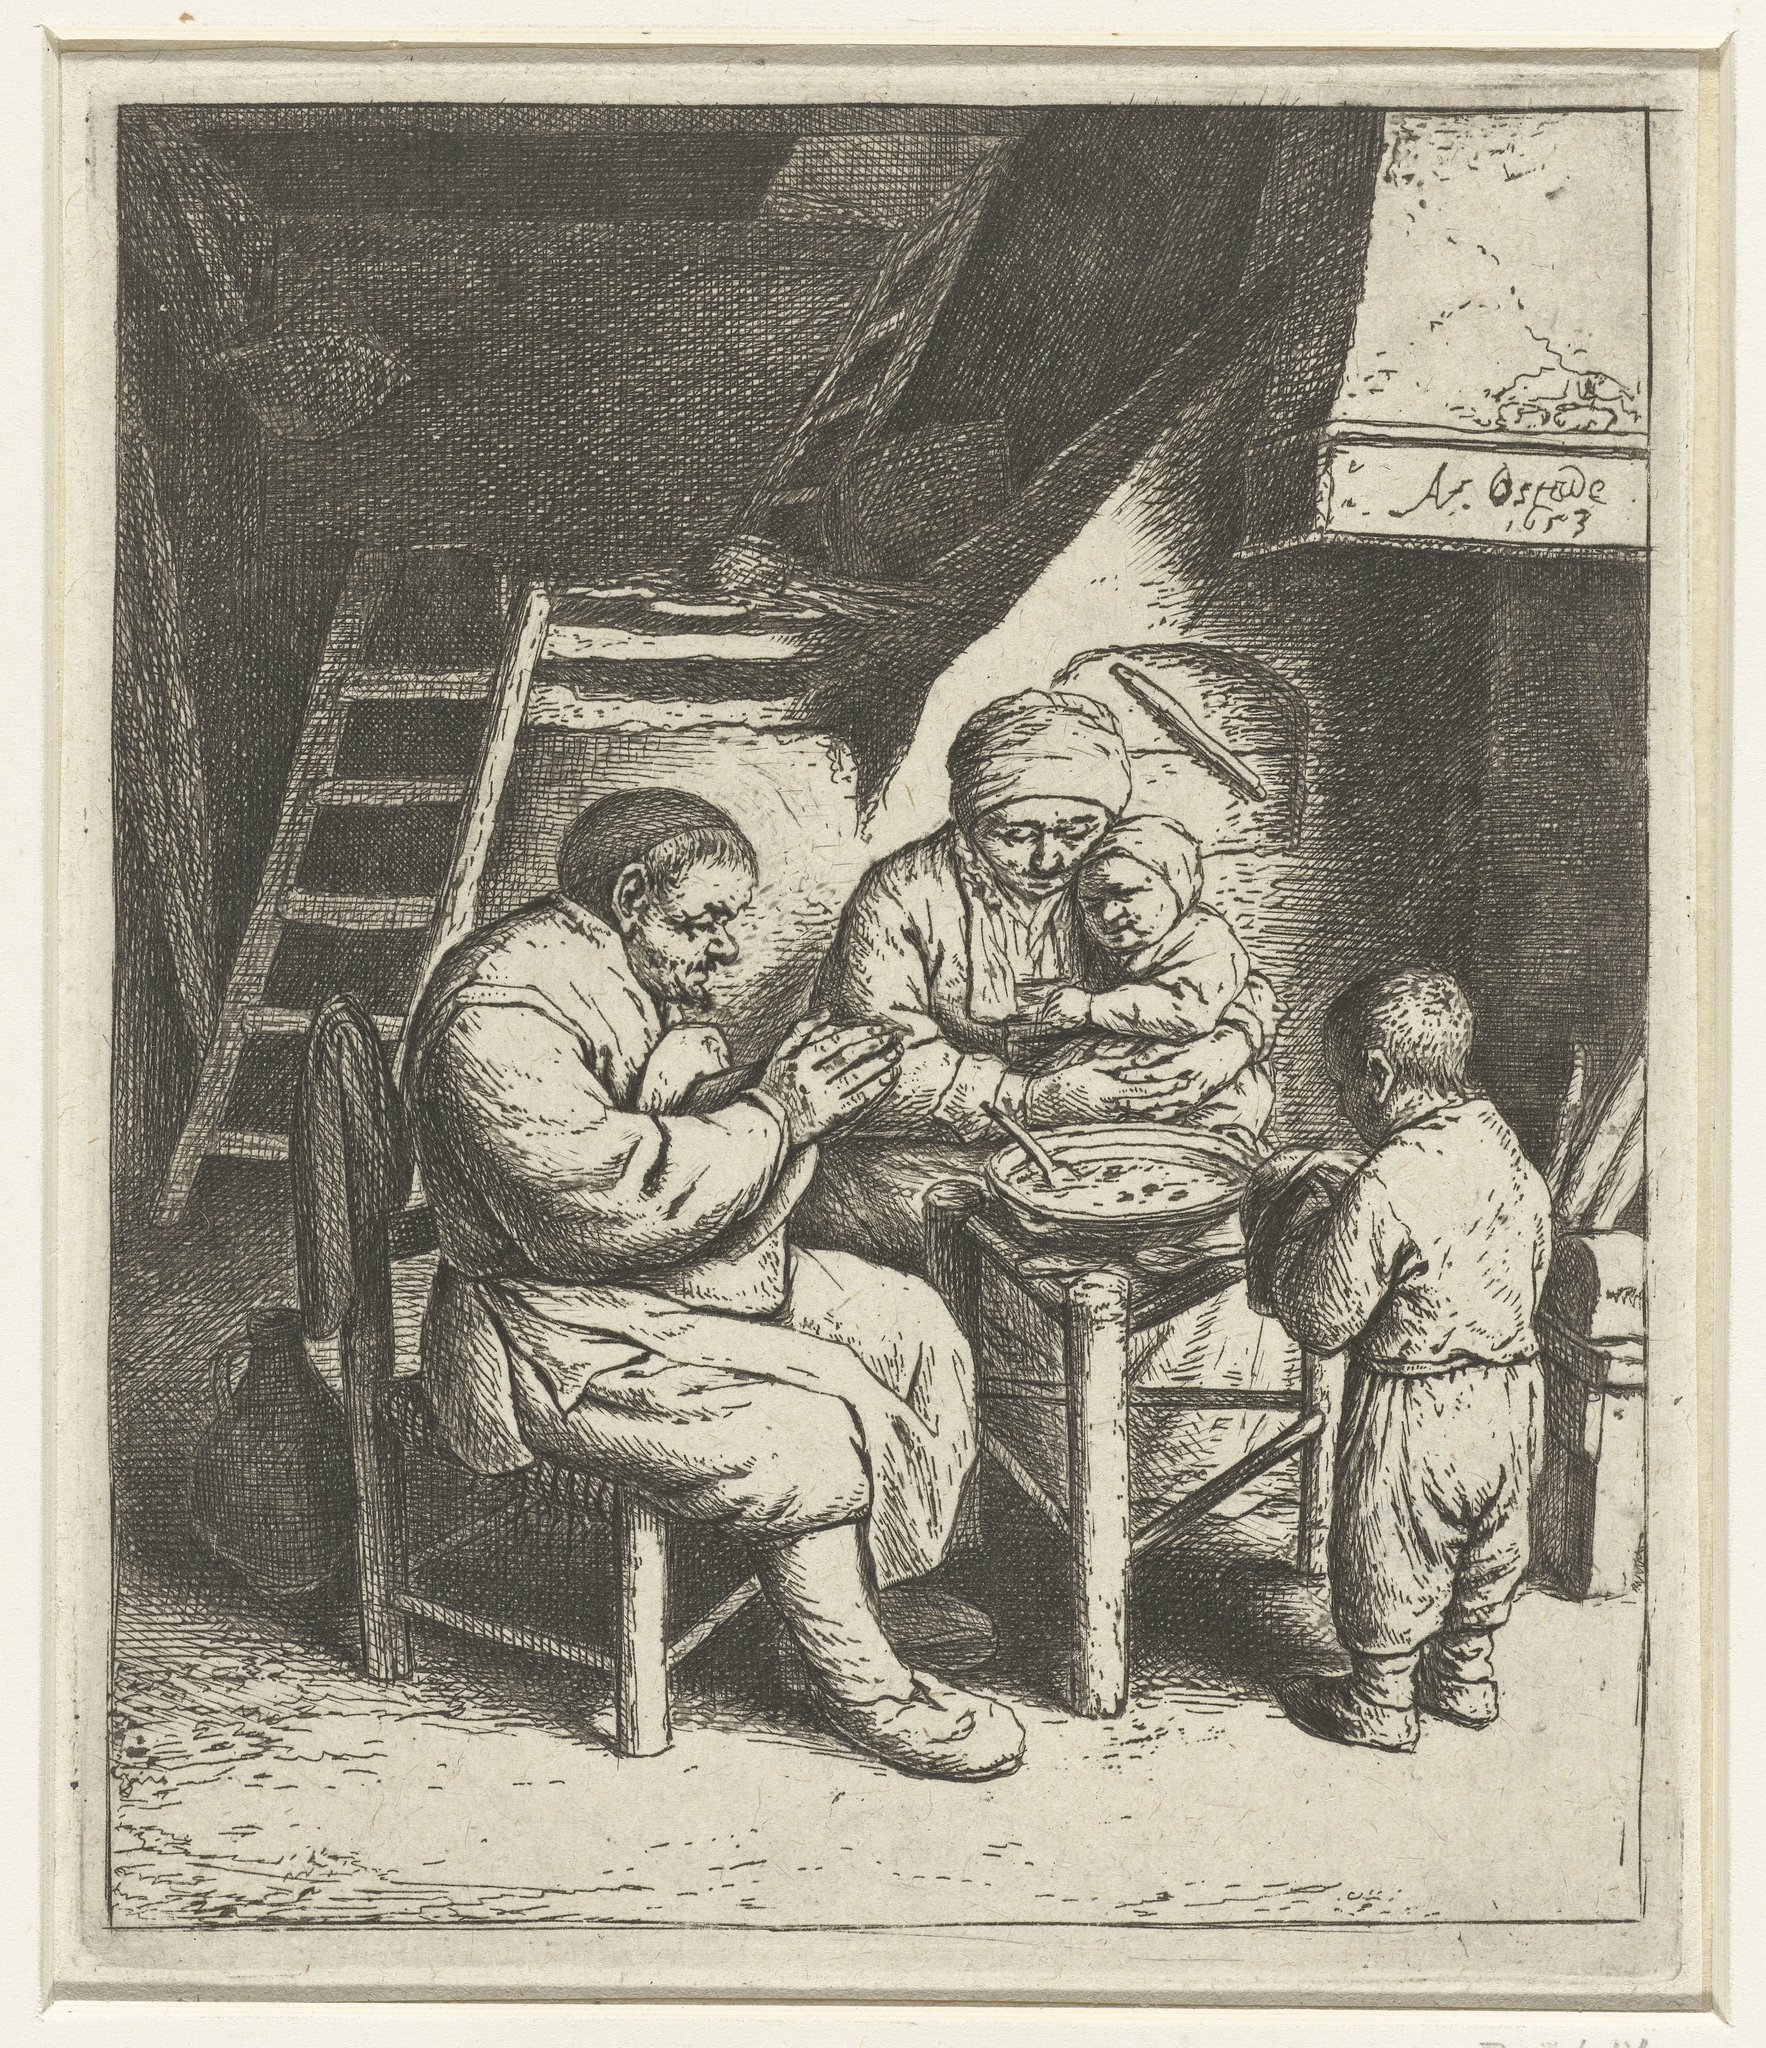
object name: print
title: Gezin aan tafel voor de maaltijd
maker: adriaen van ostade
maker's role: draughtsman, painter, print maker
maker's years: 1610-1685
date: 1653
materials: paper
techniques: etching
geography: haarlem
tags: family life, prayer at table, saying grace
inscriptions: collector's mark: Lugt 2228a, collector's mark: Lugt 2610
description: Een vader en moeder met twee kinderen zitten bij een kleine tafel met hun handen gevouwen voor het gebed. Op de tafel staat een grote pan met eten. Het gezin zit vlakbij een haard in een sober ingericht vertrek.